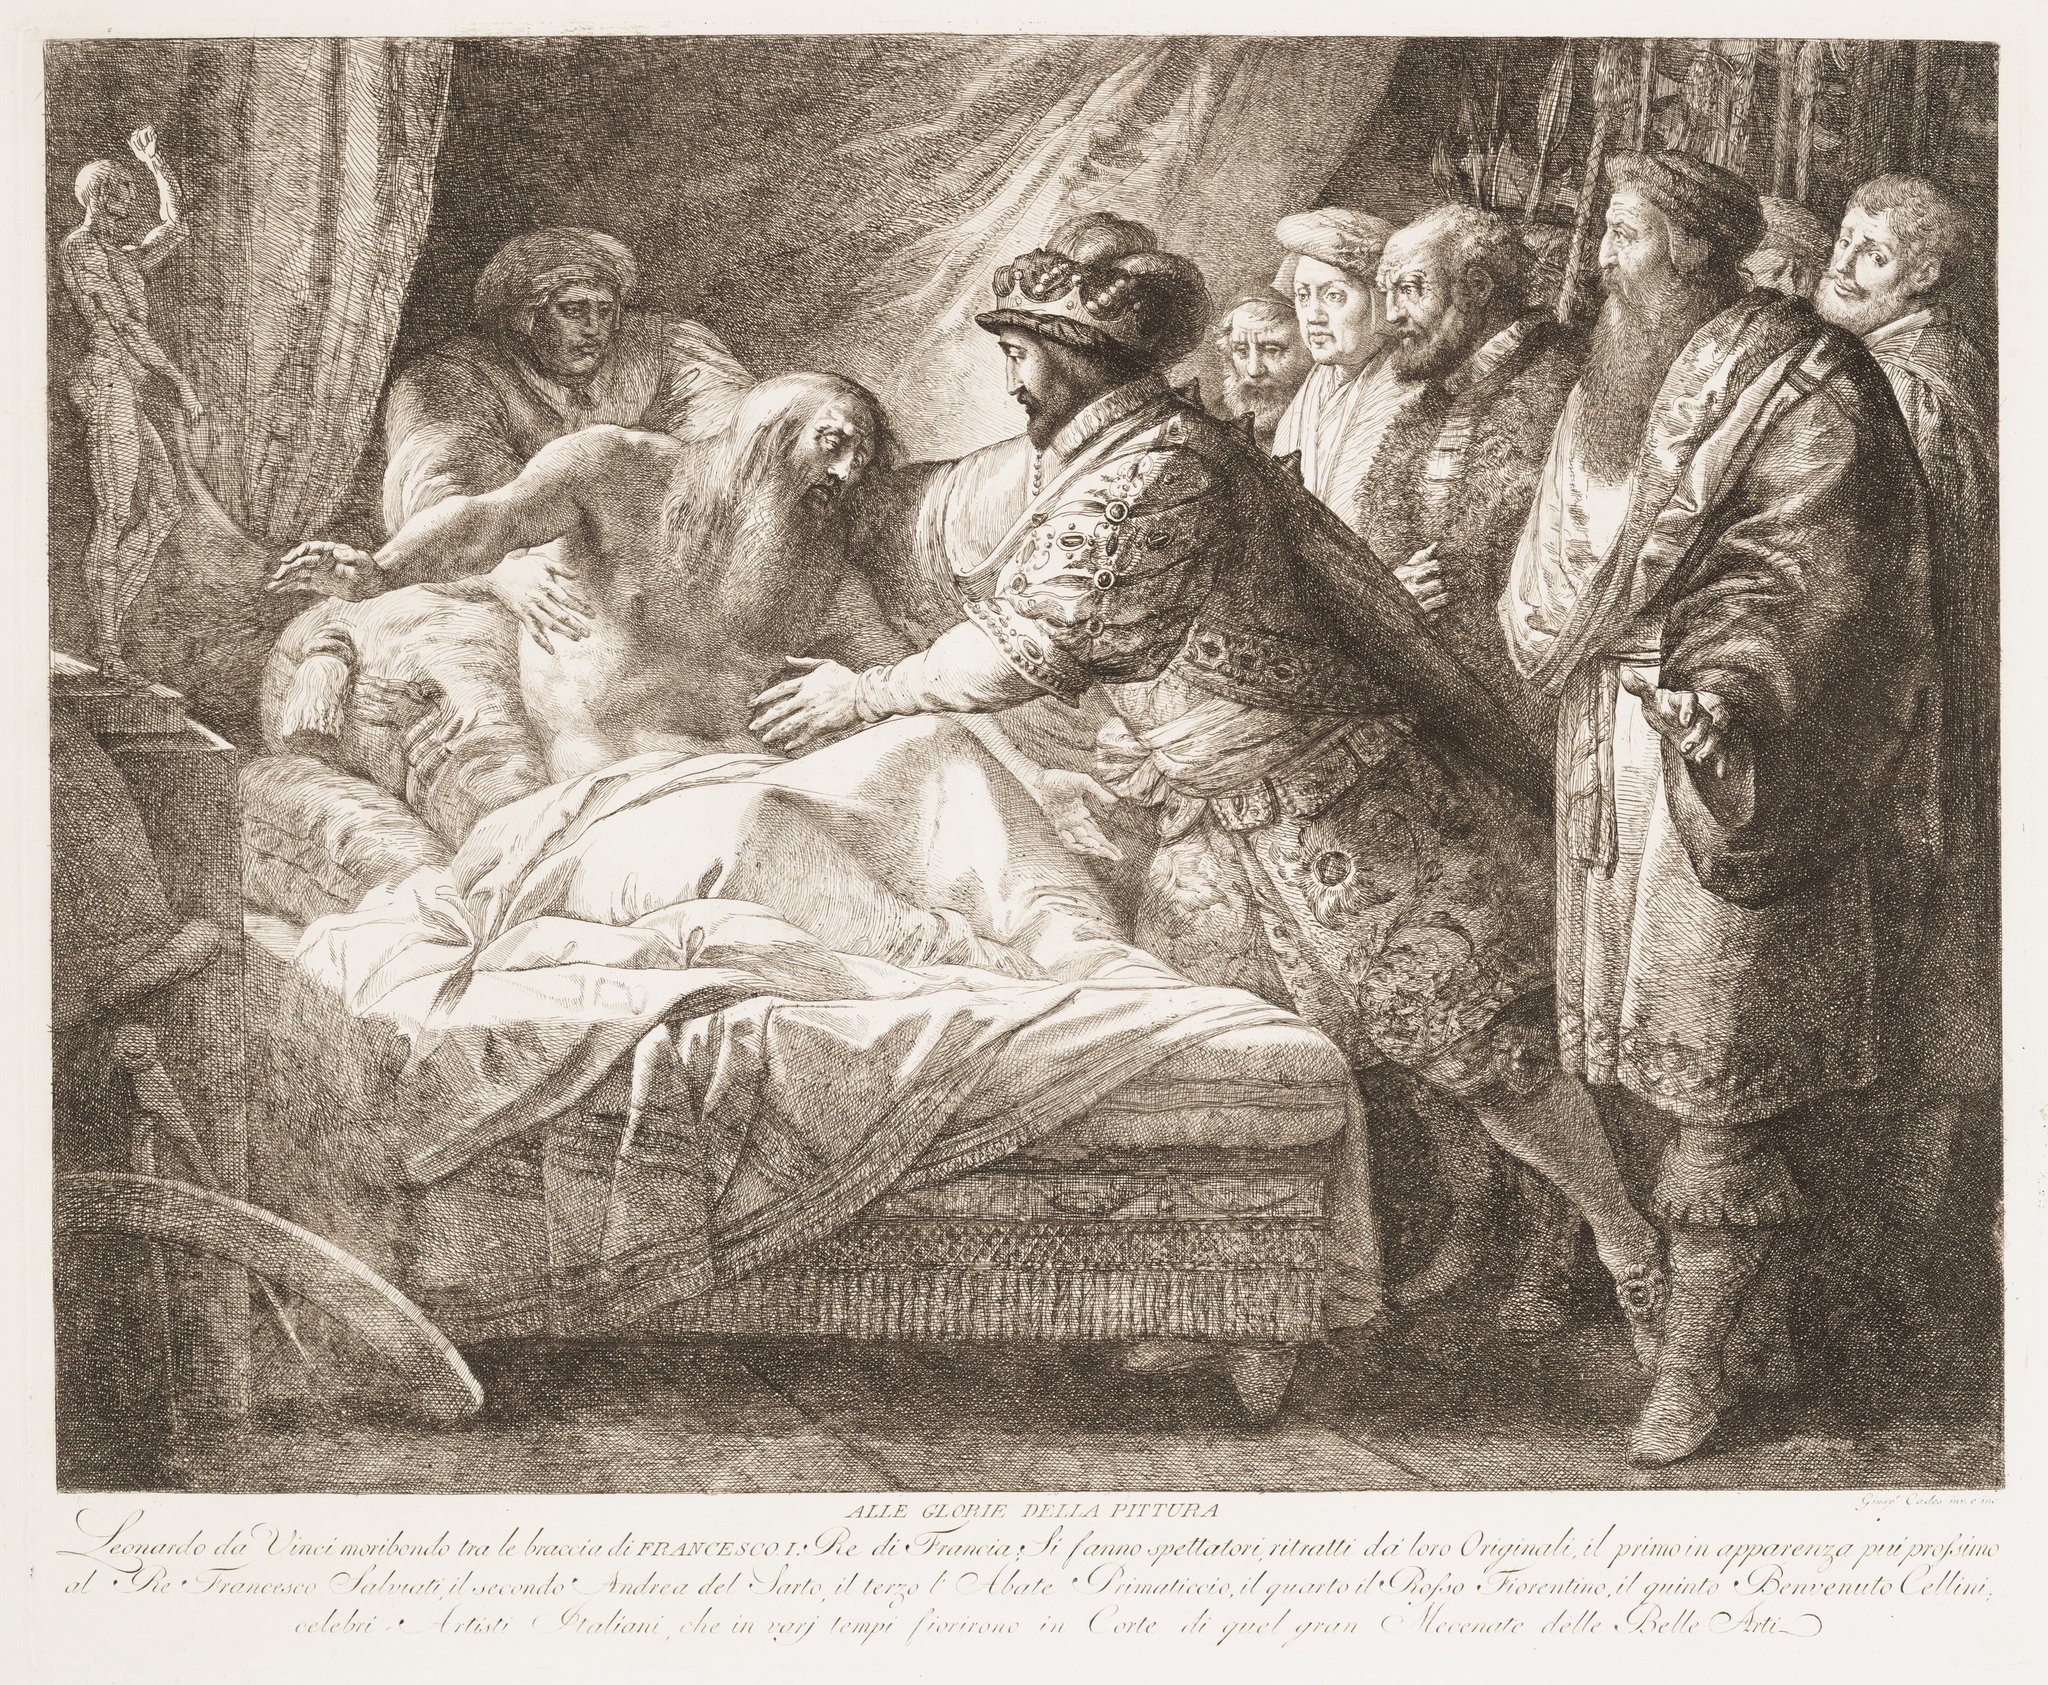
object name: print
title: Allegory of Painting (The Death of Leonardo da Vinci)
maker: giuseppe cades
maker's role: artist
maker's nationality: italian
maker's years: 1750-1799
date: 1780-1799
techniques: etching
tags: men,beds